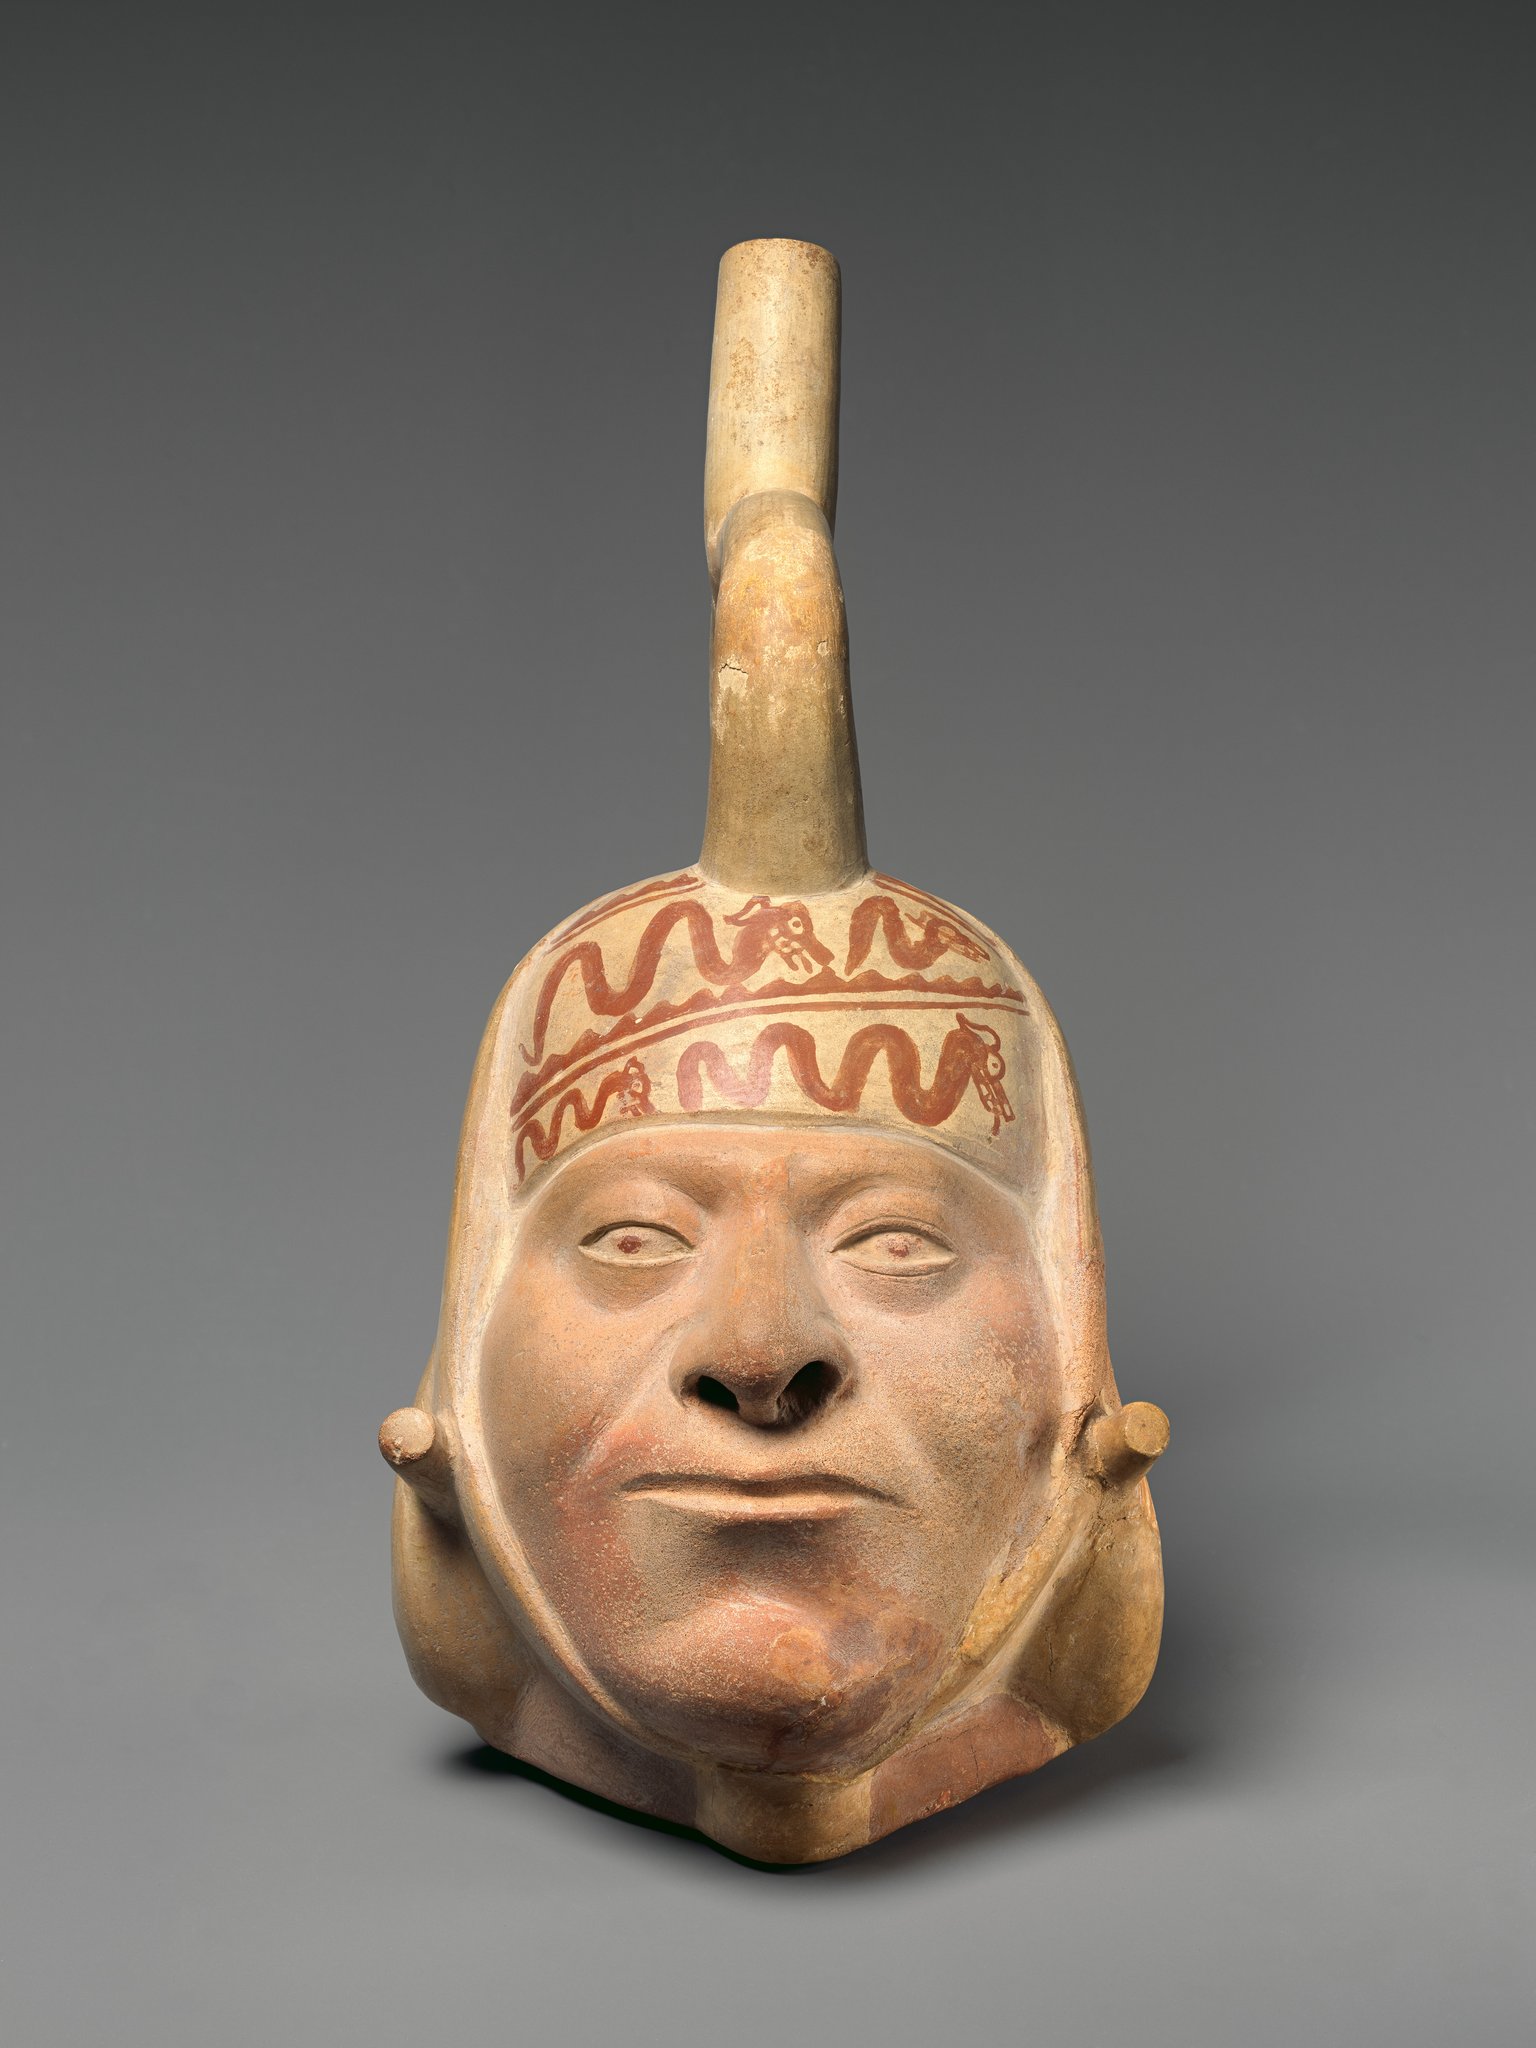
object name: bottle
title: Bottle with portrait head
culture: moche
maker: moche artist(s)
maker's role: artist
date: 500-800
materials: ceramic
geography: peru